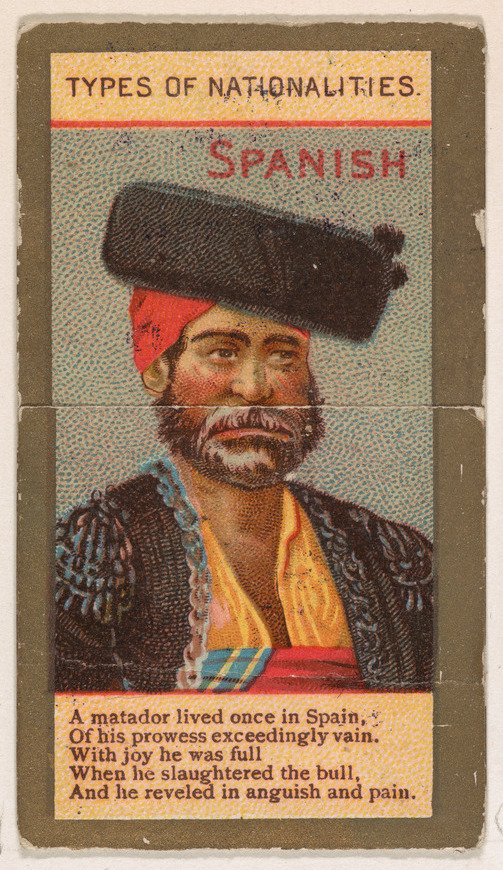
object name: print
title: Spanish, from Types of Nationalities (N240) issued by Kinney Bros.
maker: kinney brothers tobacco company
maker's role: publisher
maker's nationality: american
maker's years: 1869-2011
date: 1890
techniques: color lithograph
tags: men